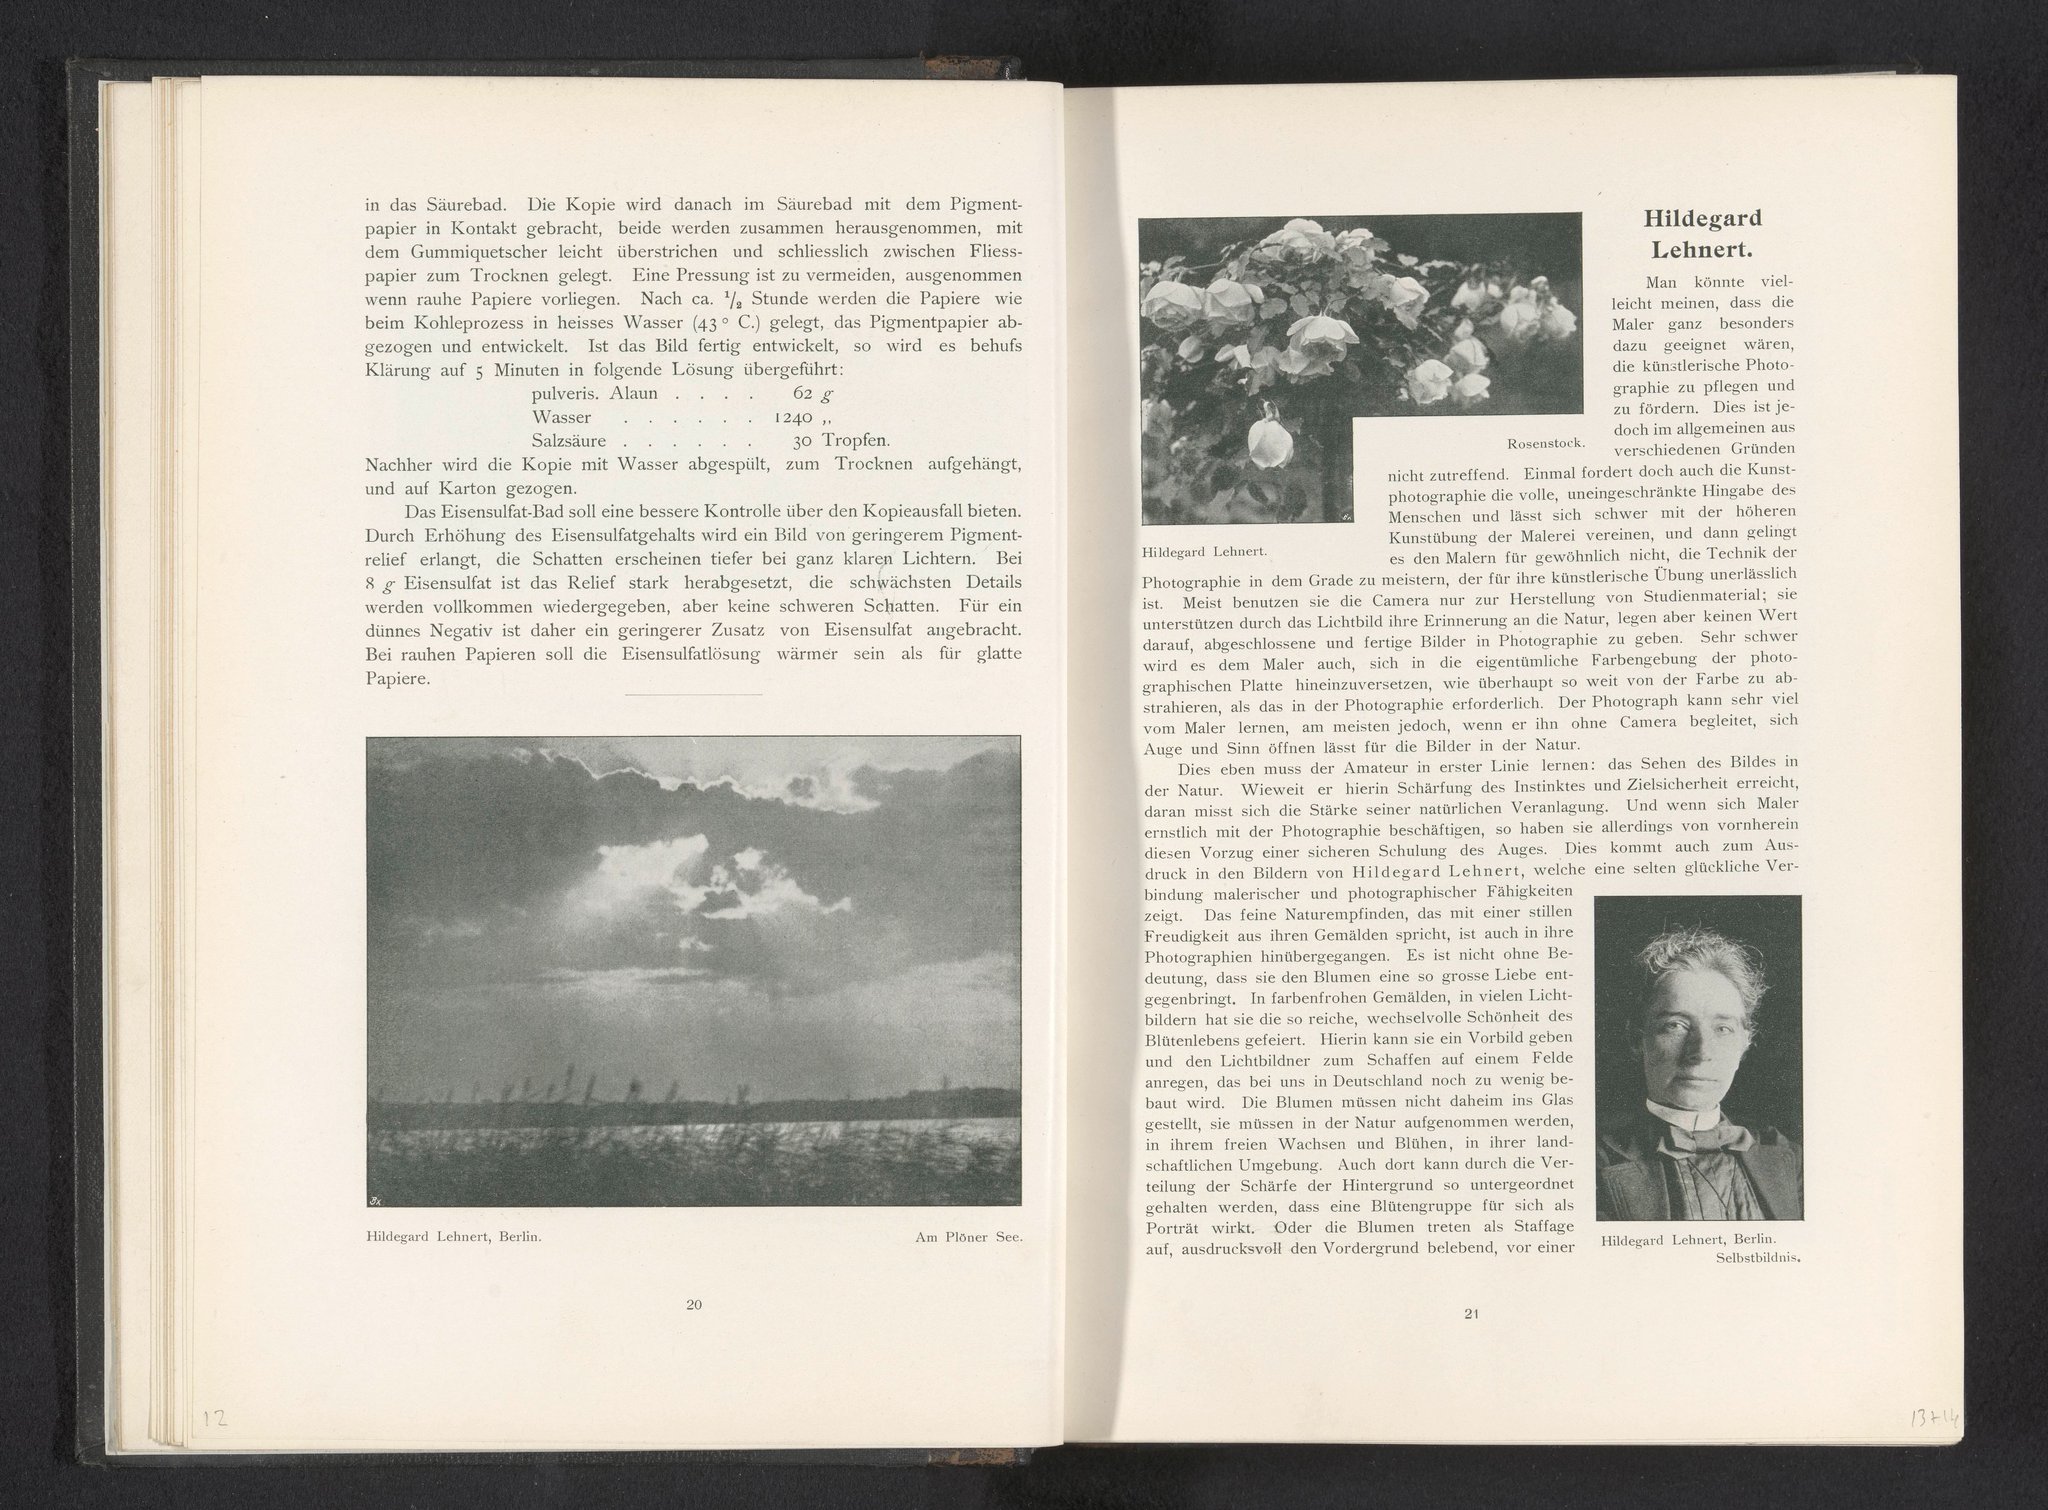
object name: page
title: Am Plöner See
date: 1898-1903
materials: paper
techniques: autotype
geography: schleswig-holstein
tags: landscapes, lake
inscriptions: monogram: ‘BX’, inscription: ‘Berlin’